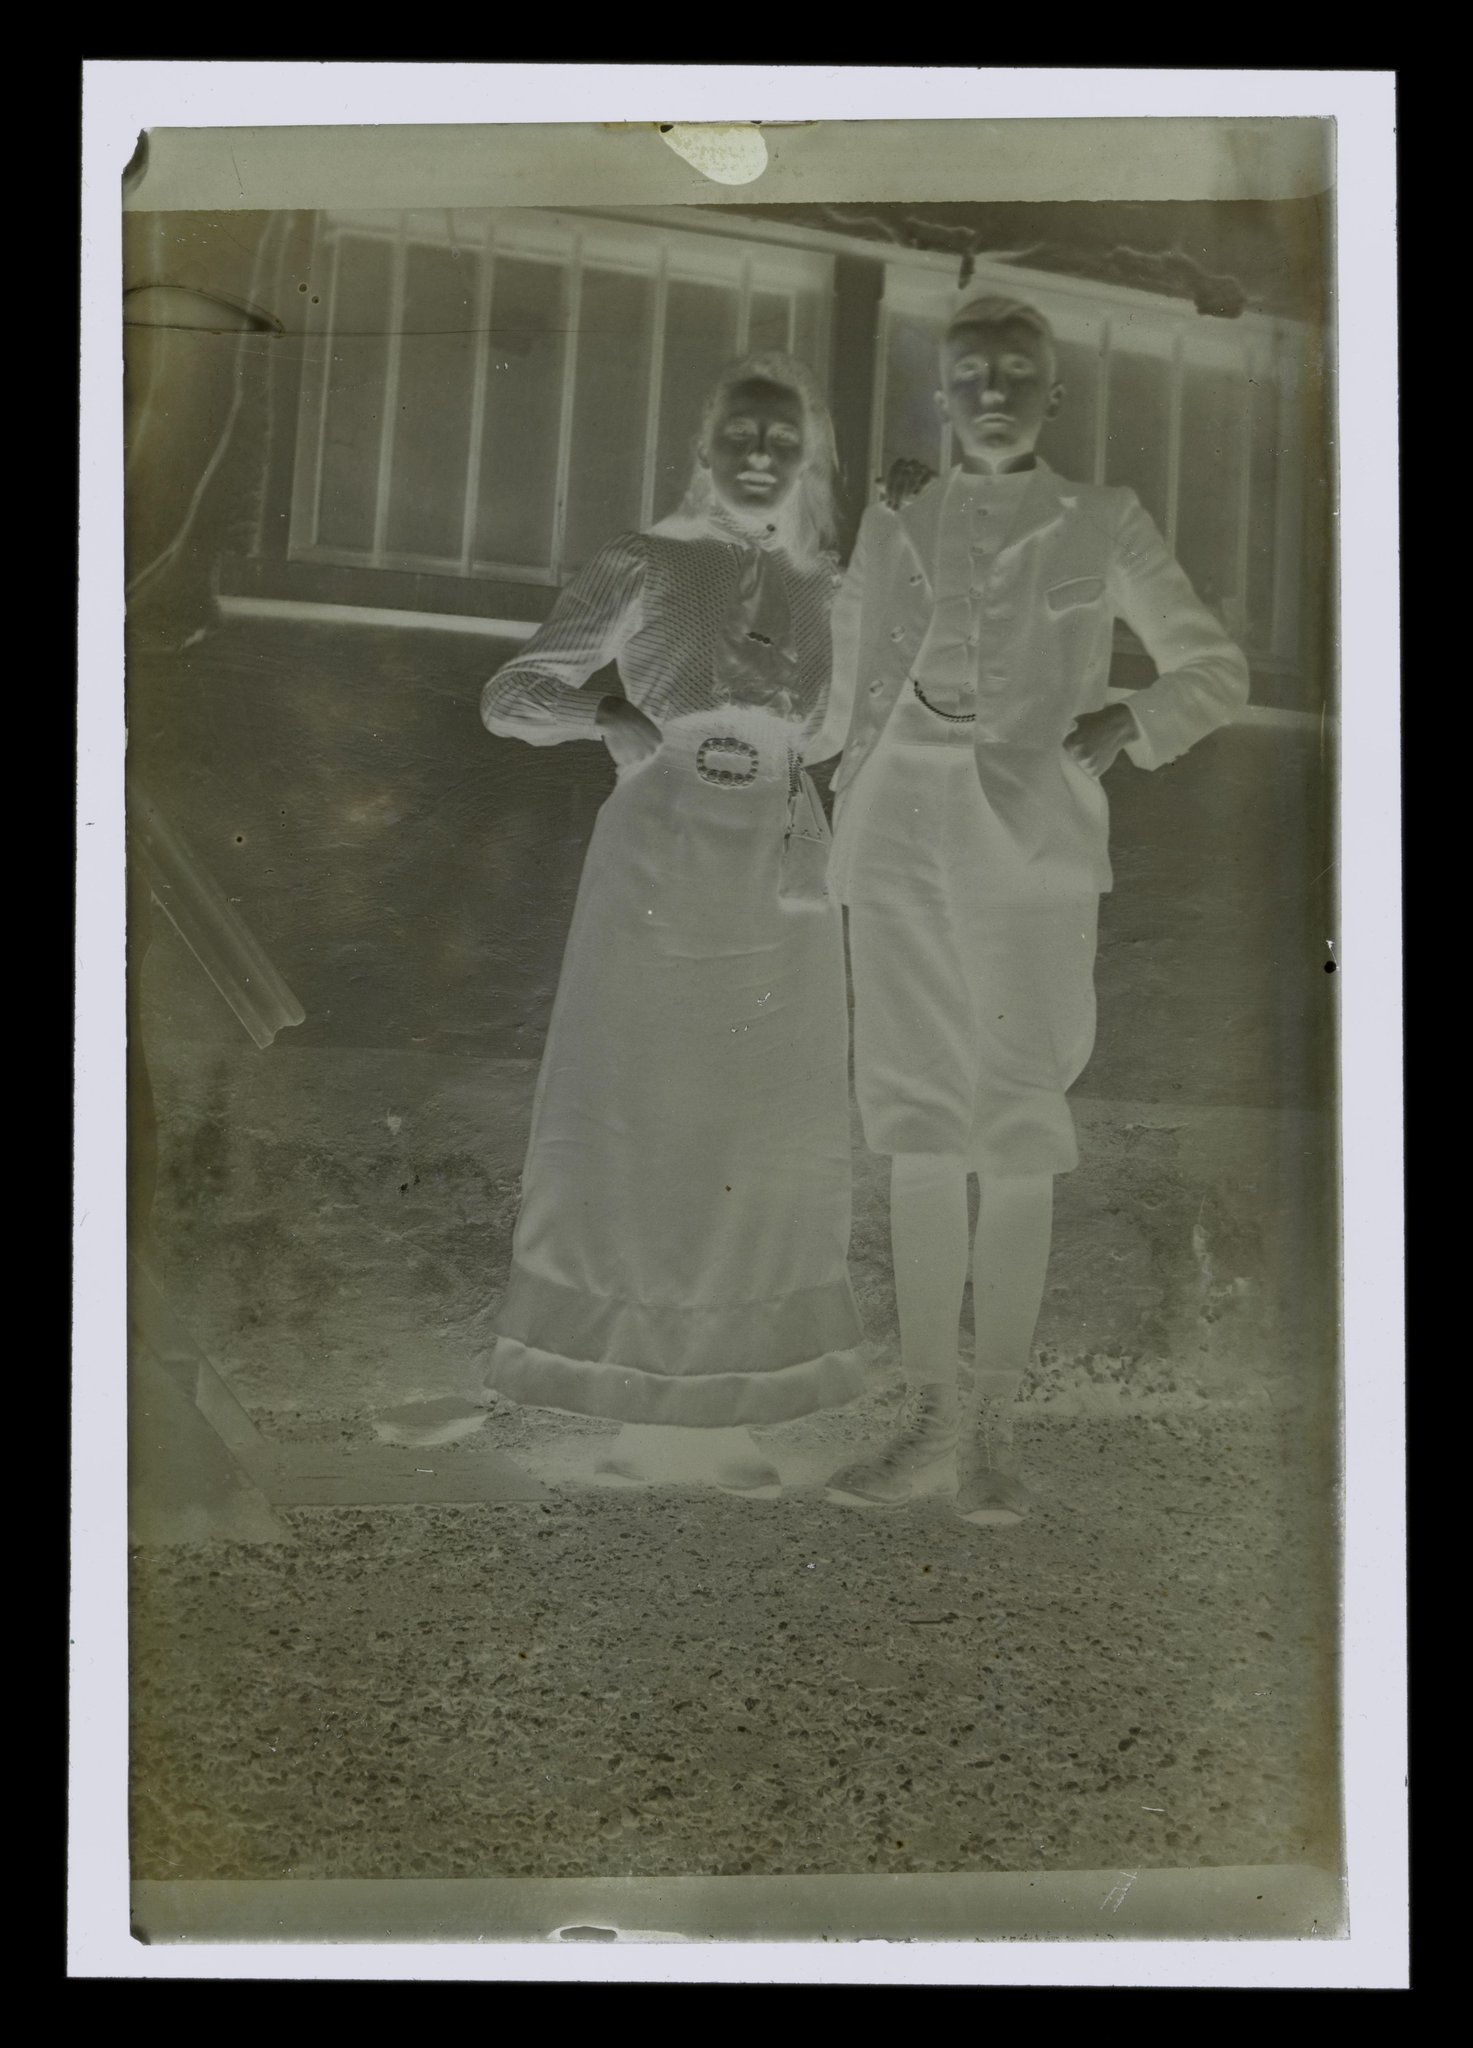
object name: glasnegatief, glasplaatnegatief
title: Portret van een onbekende man en vrouw in een tuin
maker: laurens lodewijk kleijn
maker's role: draughtsman, painter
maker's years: 1826-1909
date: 1865-1900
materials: glass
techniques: collodion process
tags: adult woman, garden, adult man, historical persons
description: Onderdeel van groep glasnegatieven uit de nalatenschap van de schilder Laurens Lodewijk Kleijn, stillevens, portretten, zelfportretten en kunstreproducties.